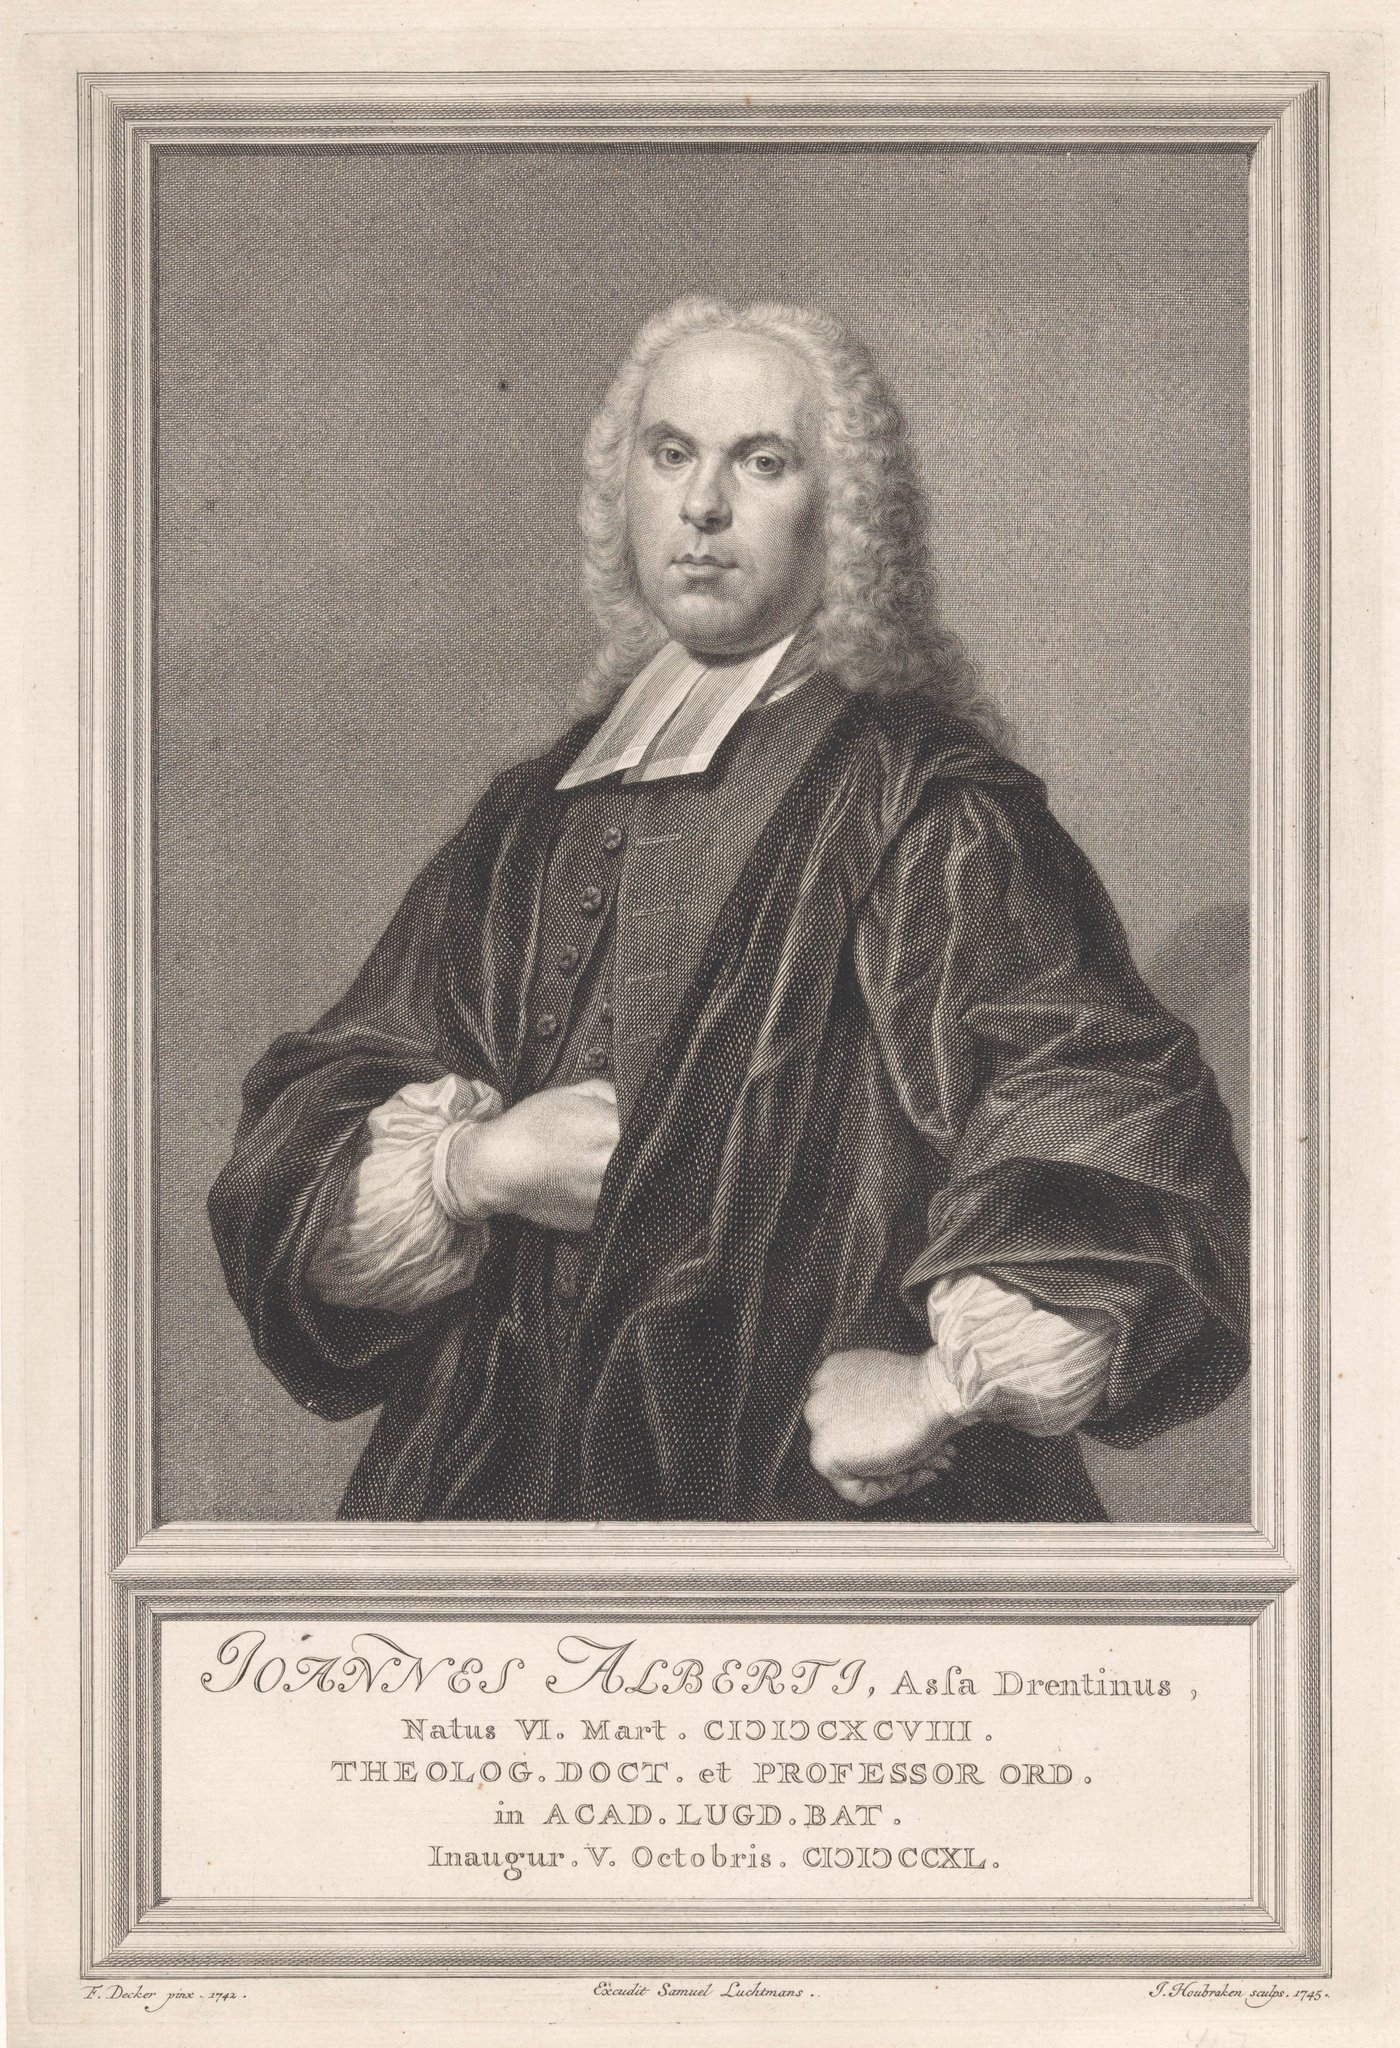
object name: print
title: Portret van Johannes Alberti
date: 1745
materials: paper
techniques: engraving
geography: amsterdam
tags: leiden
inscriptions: date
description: Portret van Johannes Alberti in een rechthoekige omlijsting. In een kader zijn naam, zijn geboortedatum, zijn beroep en de datum van zijn inauguratie.